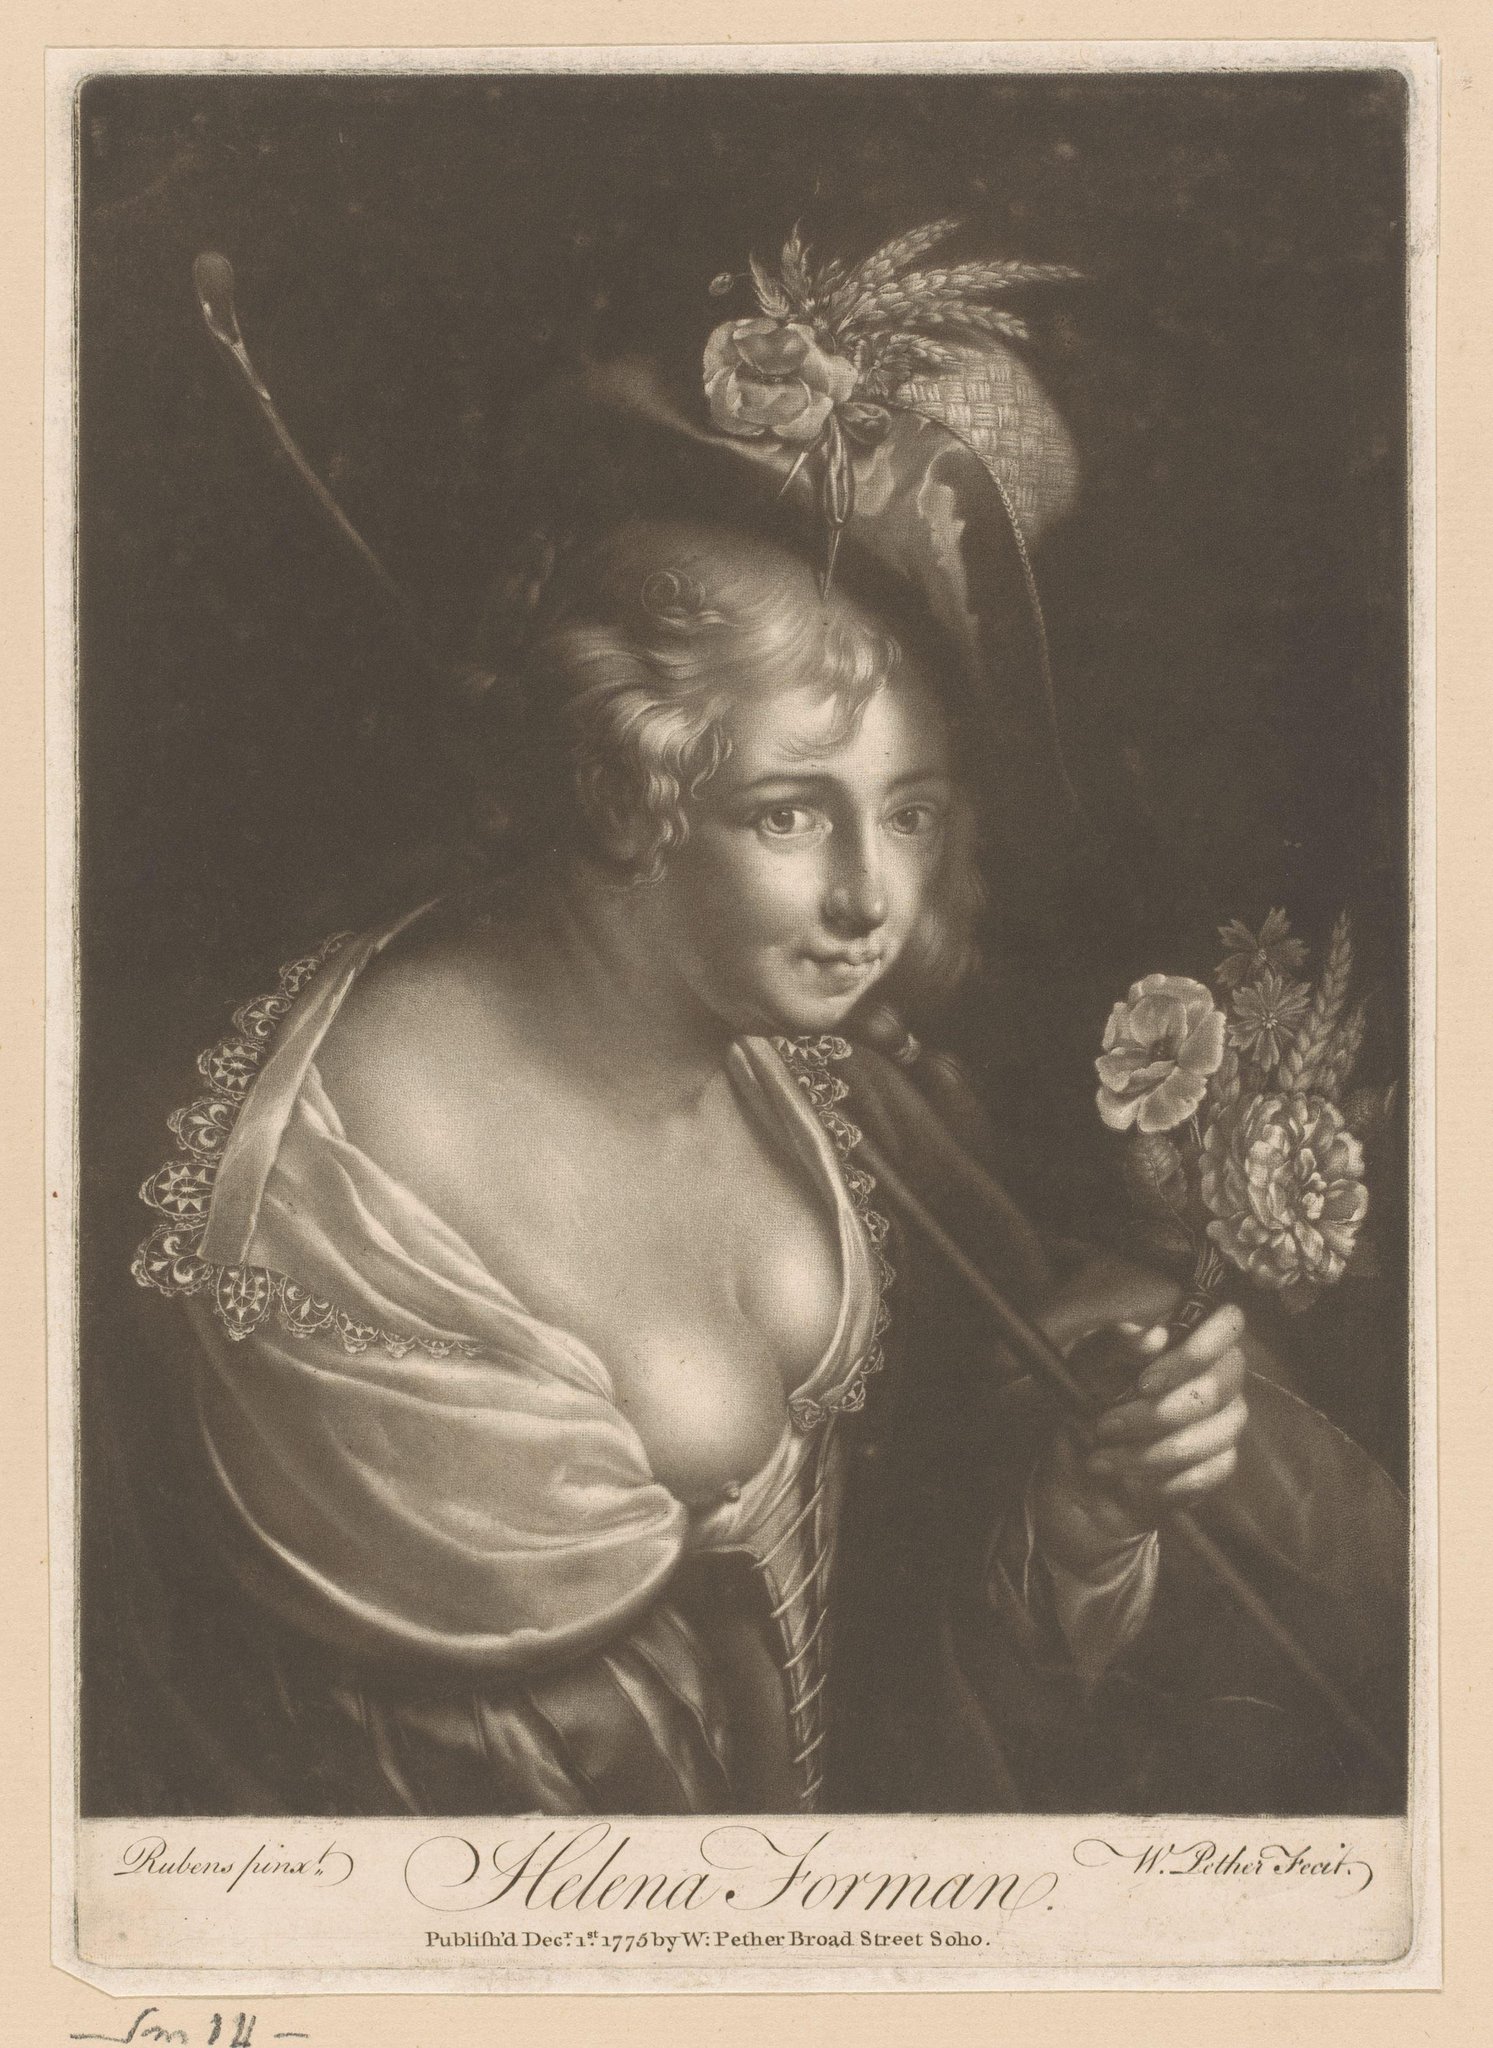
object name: print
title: Helena Forman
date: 1775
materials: paper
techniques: mezzotint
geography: london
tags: antwerp, adolescent, young woman, maiden, herding, herdsman, herdswoman, shepherd, shepherdess, cowherd, etc., historical persons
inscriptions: collector's mark: Lugt 240